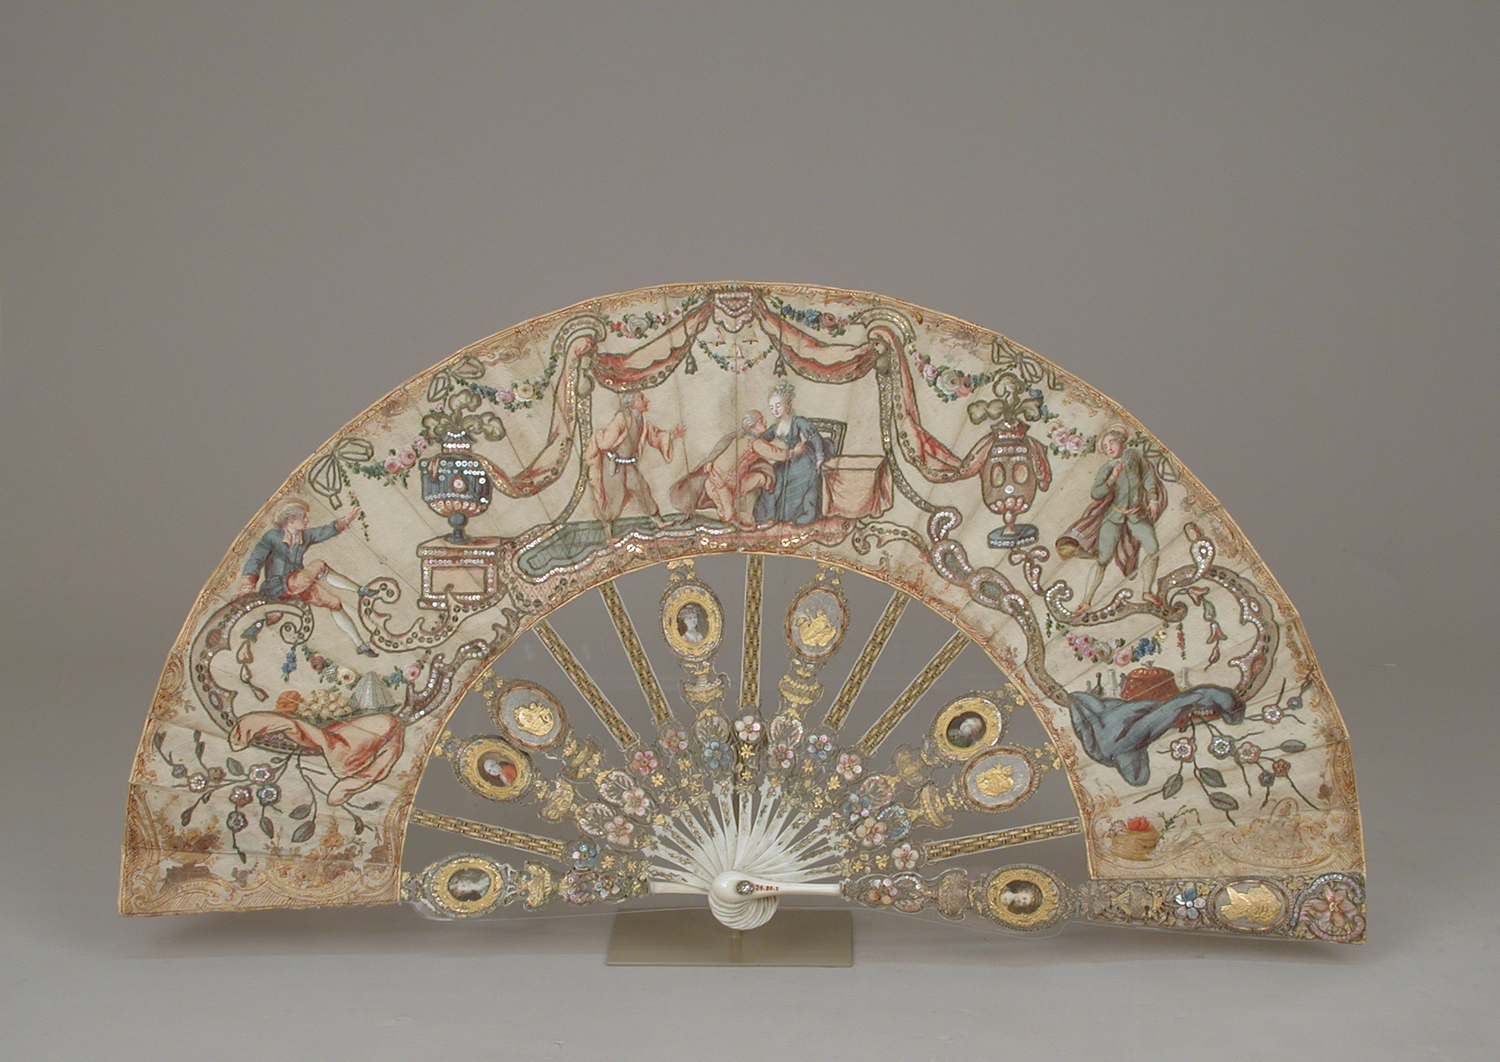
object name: fan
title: Folding fan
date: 1774-1793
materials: ivory, silk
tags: men,women